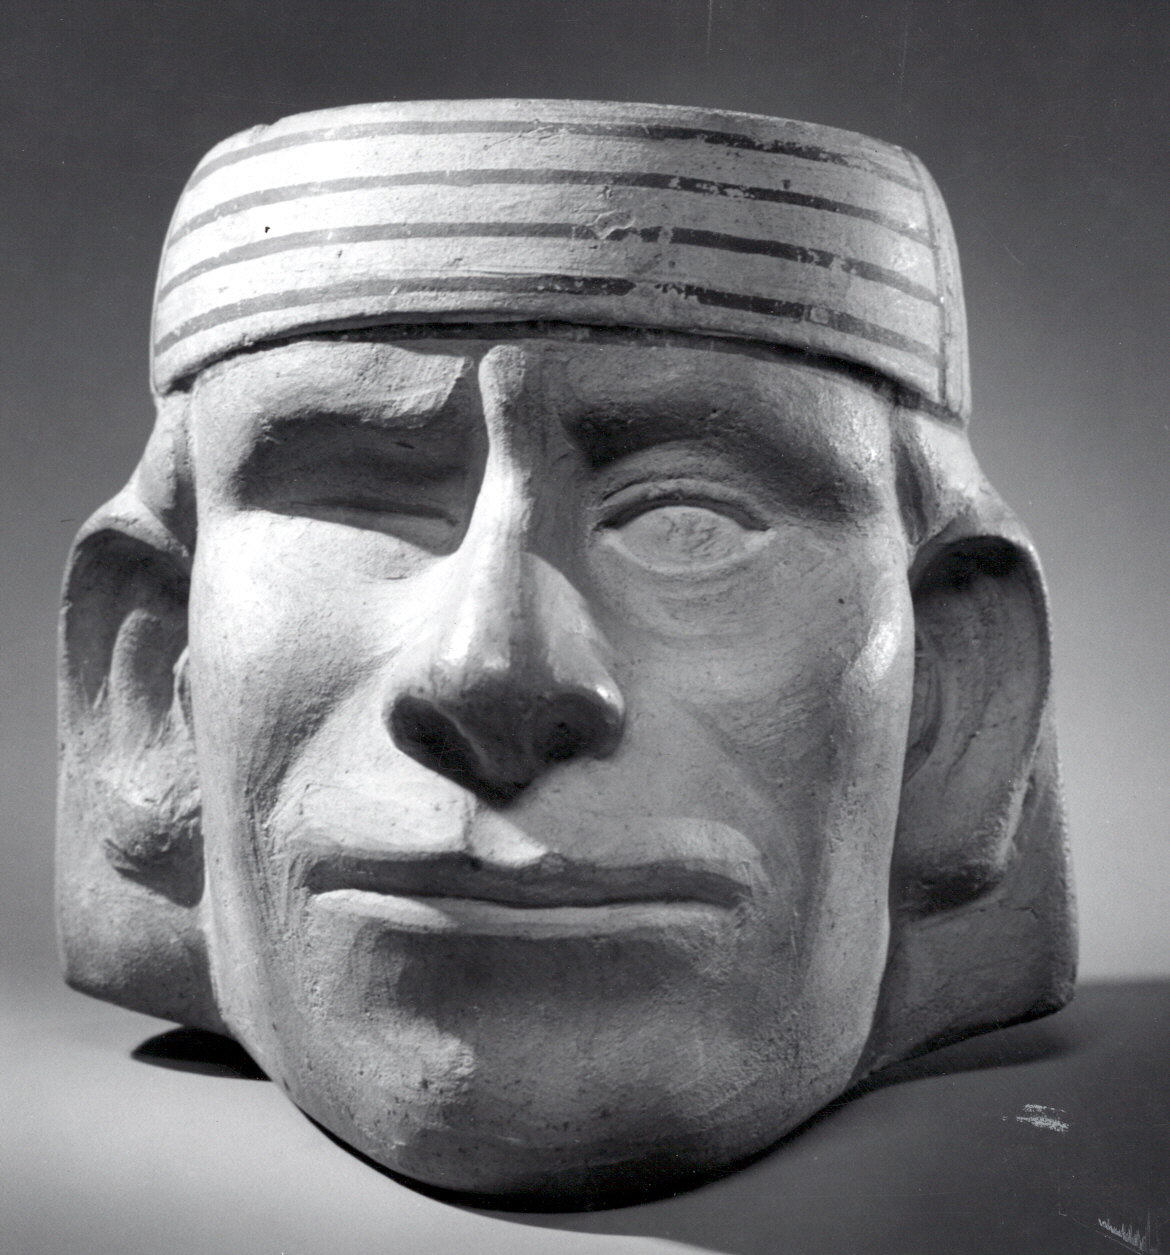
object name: vessel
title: Head Vessel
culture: moche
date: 101-600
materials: ceramic, pigment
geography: peru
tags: heads